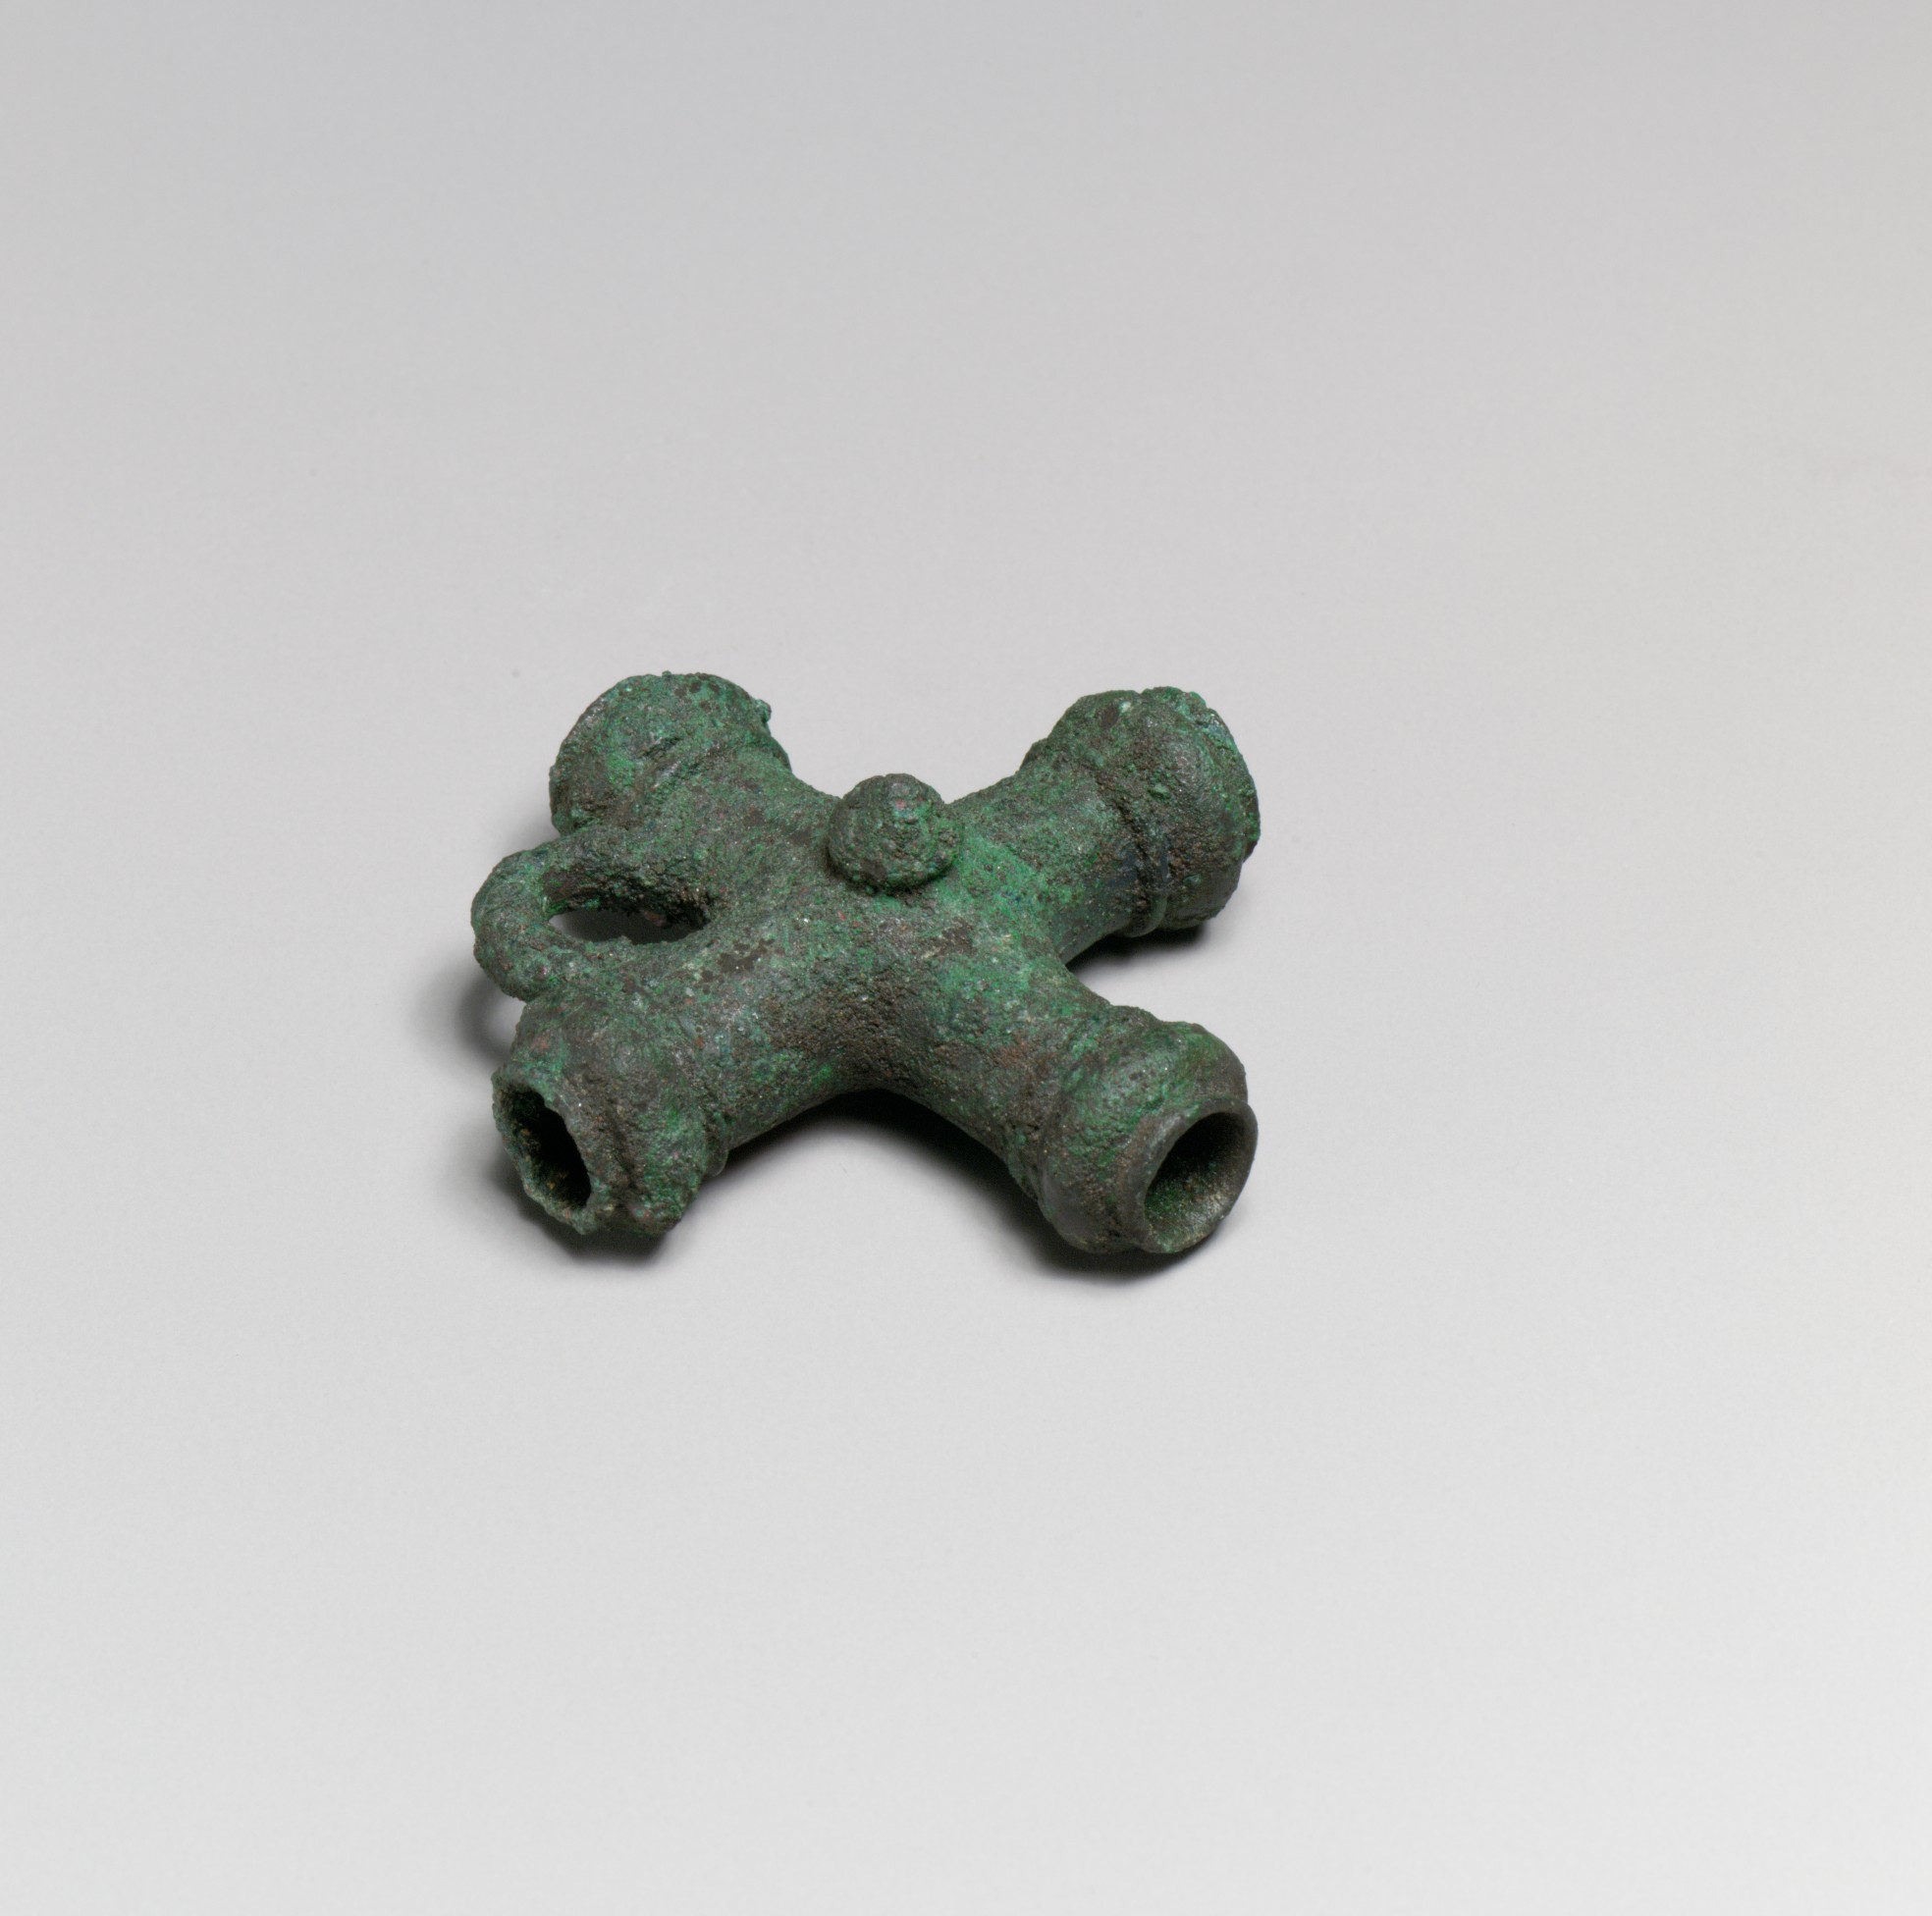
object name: chariot fragment, crossed cylinder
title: Fragments of a cart or chariot, crossed cylinders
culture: etruscan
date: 500-480 BCE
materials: bronze